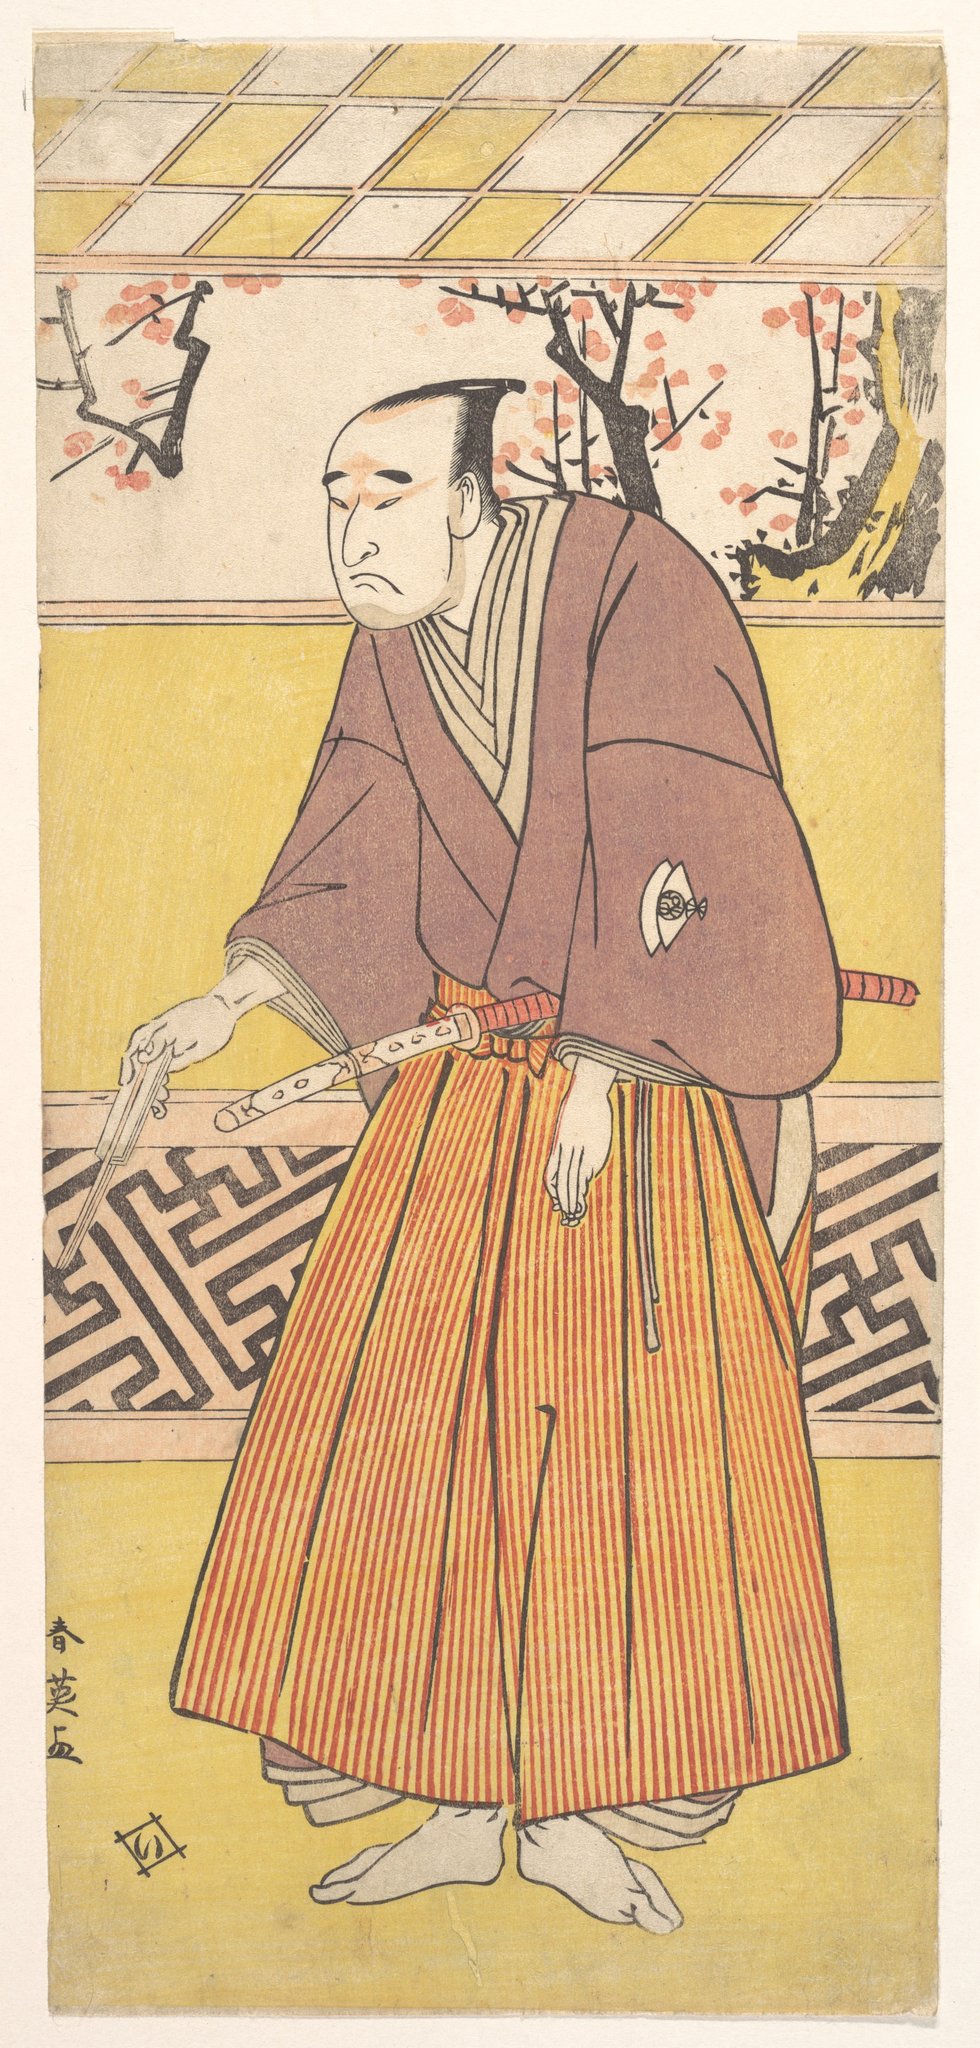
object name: woodblock print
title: The Actor Onoye Matsusuke I, as a Man Holding a Closed Fan in His Right Hand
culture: japanese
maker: katsukawa shun'ei 勝川春英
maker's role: artist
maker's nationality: japanese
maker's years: 1762-1819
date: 1780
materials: ink, paper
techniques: woodblock print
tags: fans,swords,men,actors